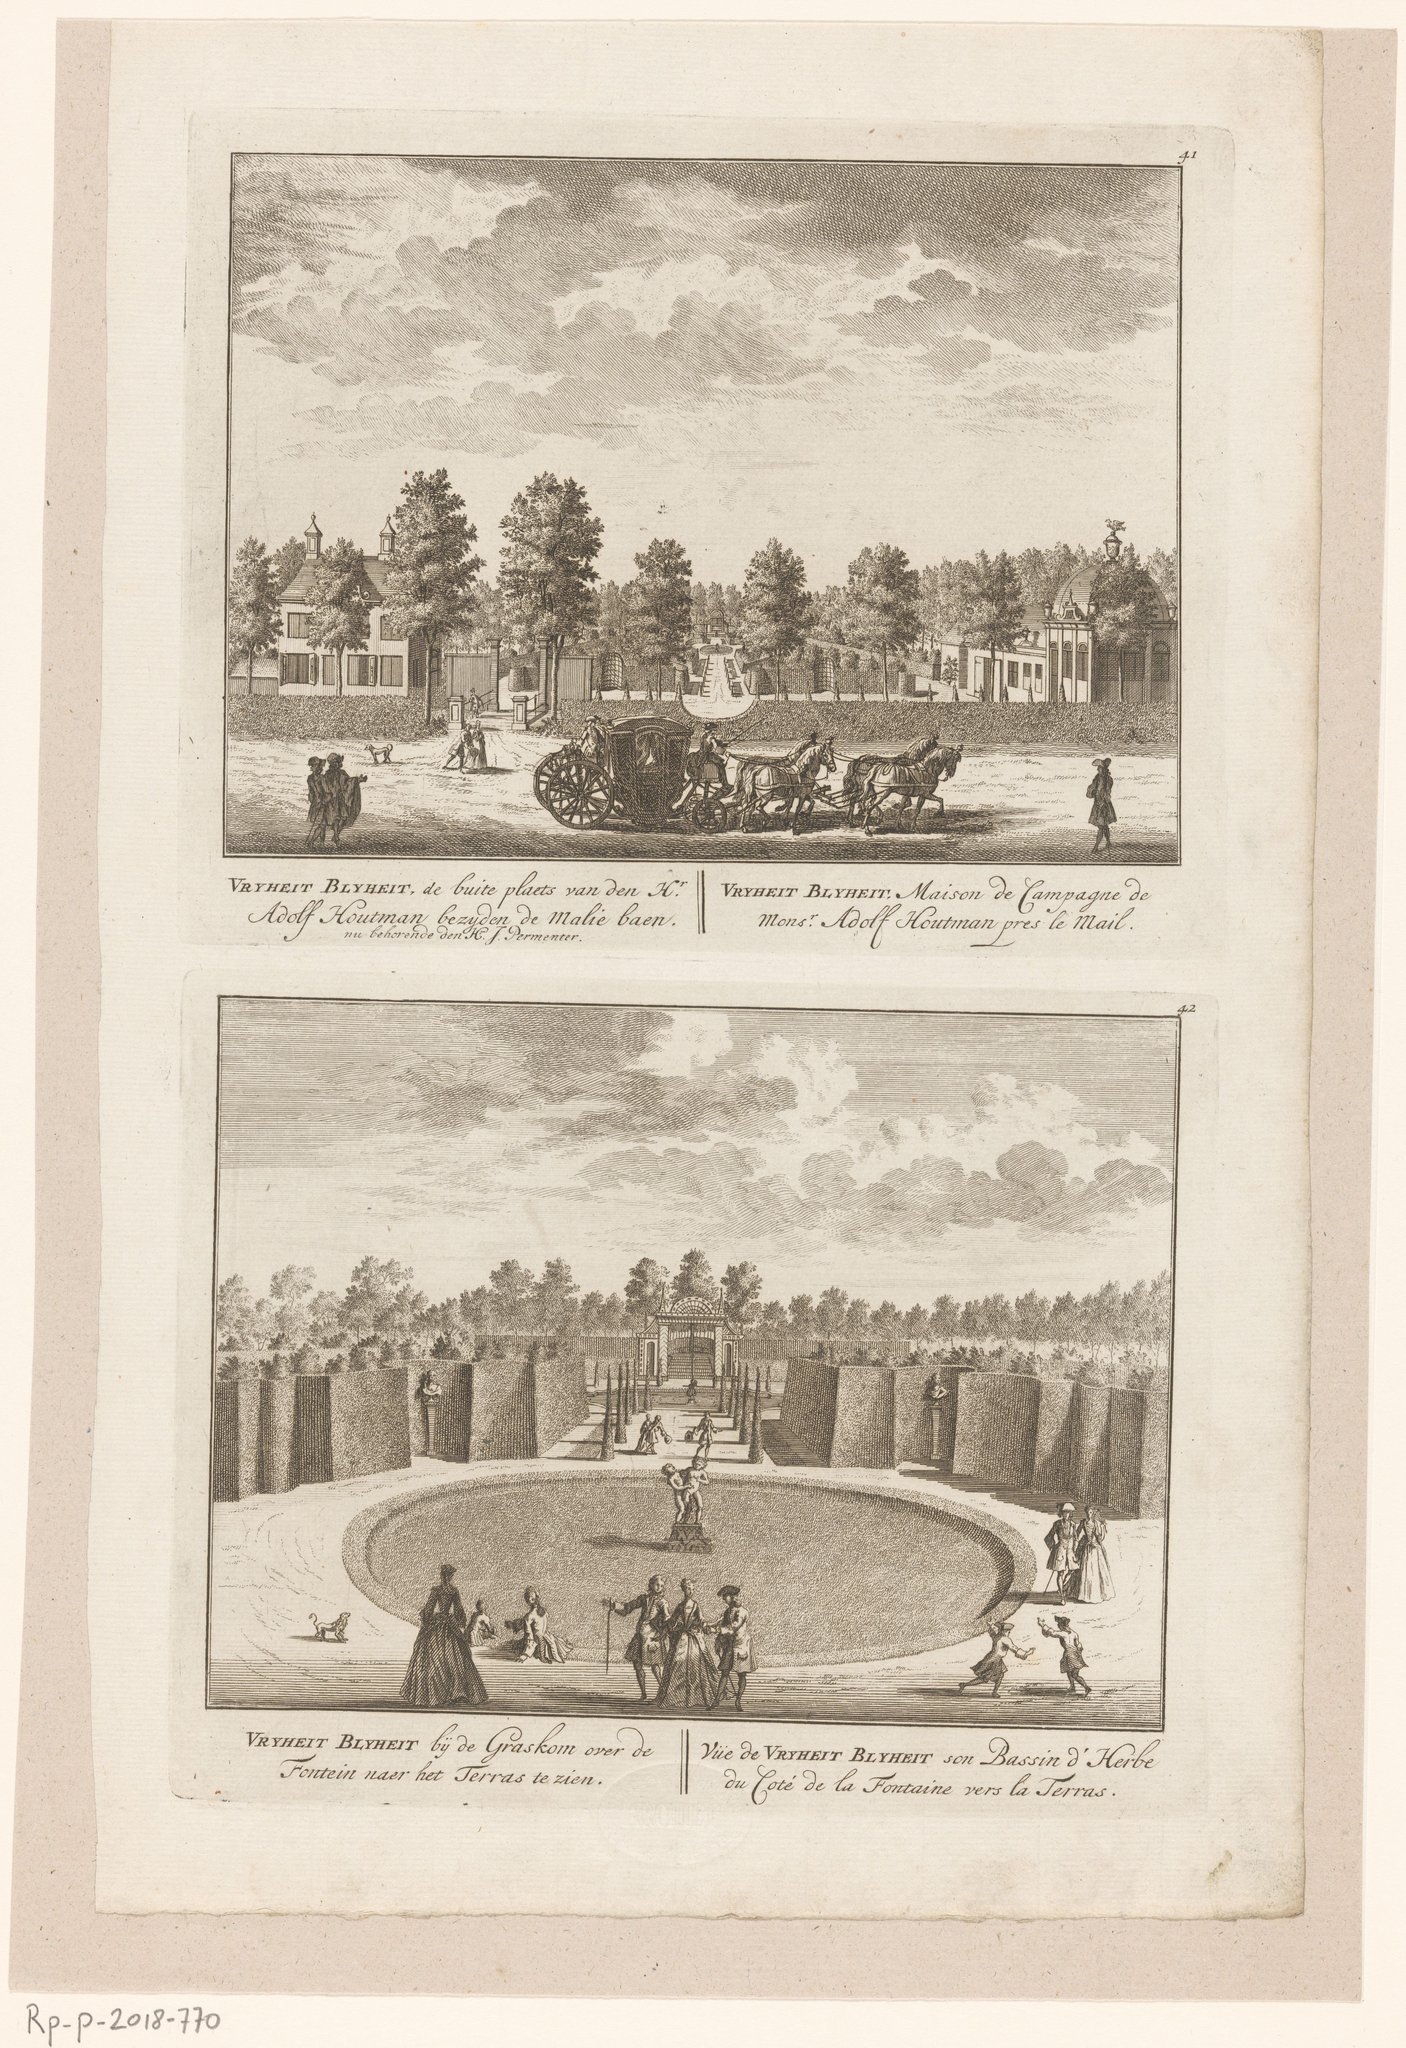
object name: book illustration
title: Gezicht op buitenplaats Vrijheid Blijheid en gezicht op de tuinen van buitenplaats Vrijheid Blijheid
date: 1725-1768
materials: paper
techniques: engraving, etching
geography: amsterdam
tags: garden fountain, french or architectonic garden; formal garden, country-house, amsterdam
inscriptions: check stamp: ‘Archief Ministerie van Oorlog Afdeeling Genie’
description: Prent gebruikt in: Niedek, Mattaeus Brouërius. Het verheerlykt Watergraafs- of Diemermeer by de stadt Amsterdam (...). Amsterdam: Andries en Hendrik de Leth, 1725. Of in: Niedek, Mattaeus Brouërius. Het verheerlykt Watergraafs- of Diemermeer by de stadt Amsterdam (...). Amsterdam: Pieter Jan Entrop, 1768.